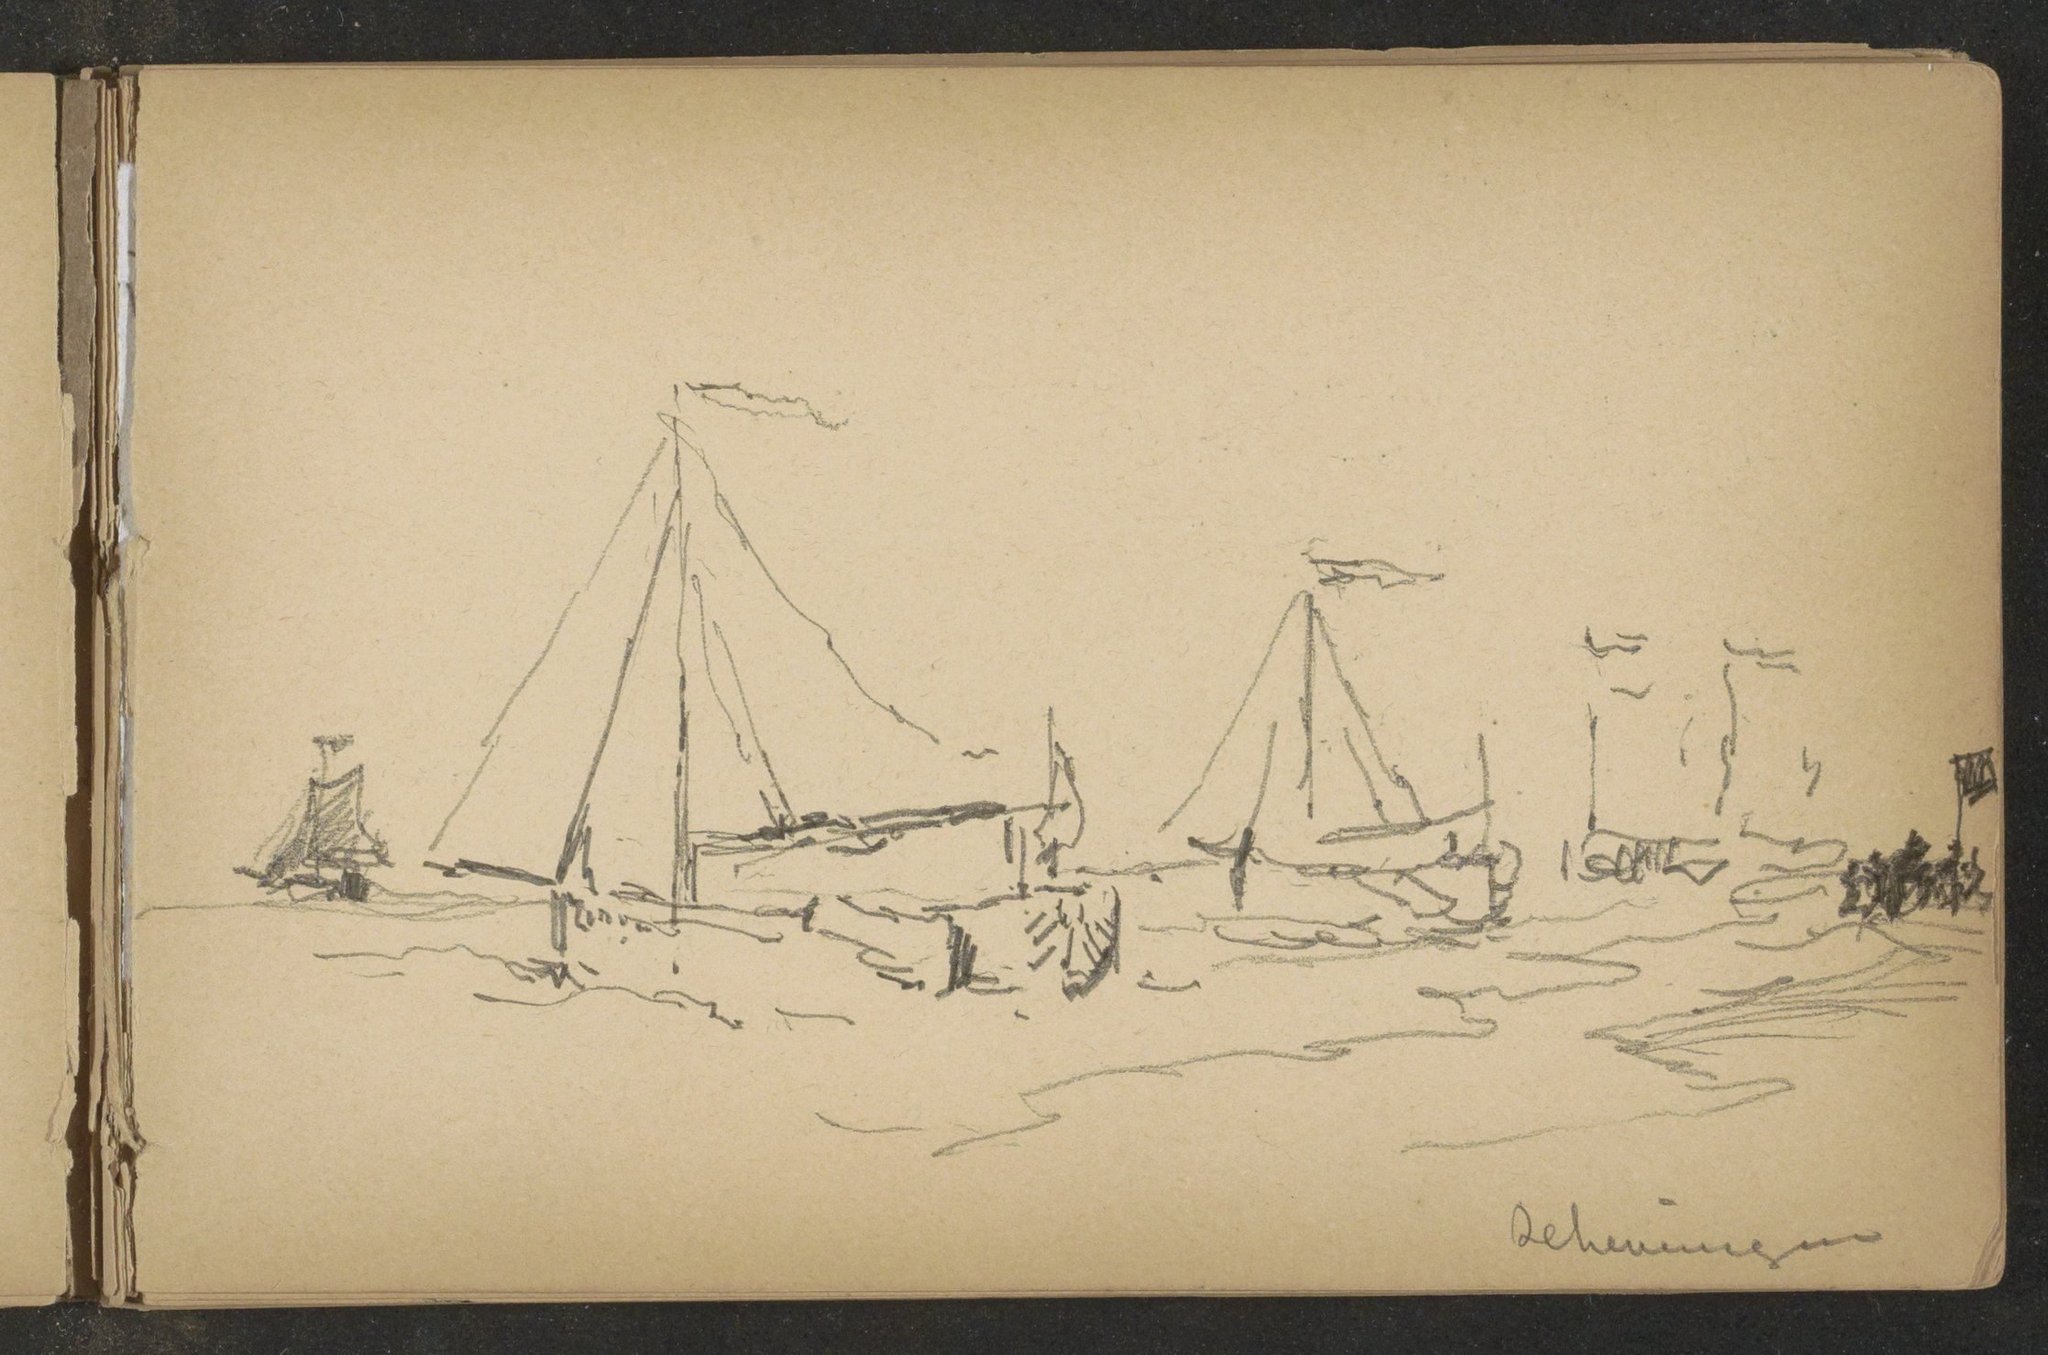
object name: sketchbook leaf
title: Zeilschepen voor de kust van Scheveningen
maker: alexander shilling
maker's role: draughtsman, print maker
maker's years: 1859-1937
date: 1809-1888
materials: paper, pencil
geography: scheveningen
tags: sailing-ship, sailing-boat, landscapes with waters, waterscapes, seascapes (in the temperate zone)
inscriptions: annotation: ‘Scheveningen’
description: Blad 6 recto uit een schetsboek met 34 bladen.